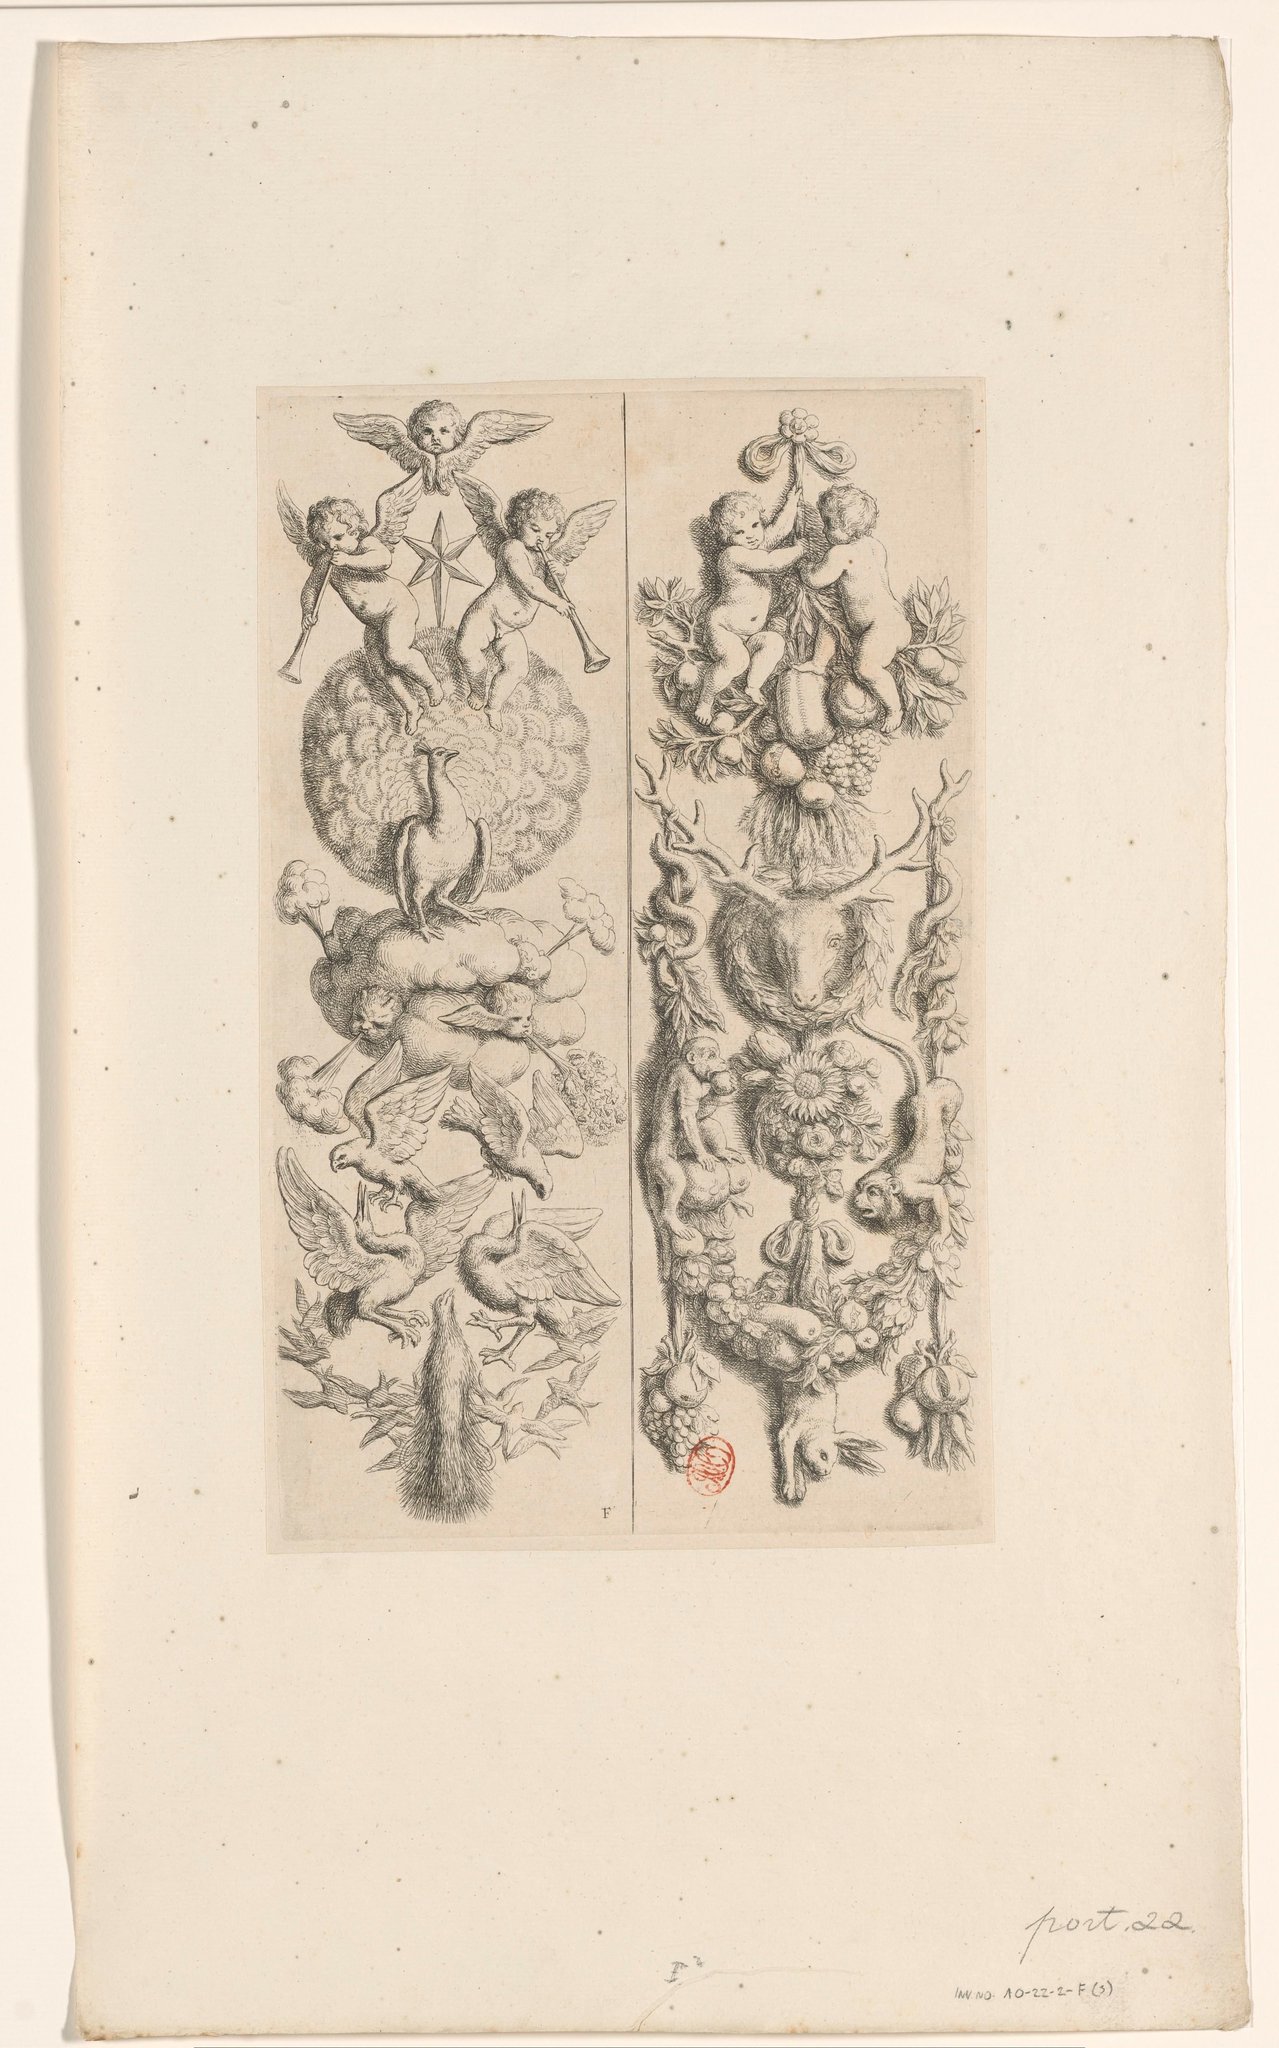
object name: book illustration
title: Festoenen met attributen van de personificaties van de elementen Lucht en Aarde aan oostzijde van de Burgerzaal in het Stadhuis op de Dam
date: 1663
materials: paper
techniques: engraving, etching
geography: amsterdam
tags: earth (one of the four elements), air (one of the four elements)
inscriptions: collector's mark: Lugt 195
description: Prent gebruikt in: Secunca pars Praecipuarum effigierum ac ornamentorum amplissime Curiae Amstelrodamensis maiori ex parte in cadido marmore effectorum per Artum Quellinium eiusdem Civitatis Statuarium / Het tweede deel Van de voornaemste Statuen ende Cieraten van 't konst-rijcke Stadt-huys van Amstelredam 'tmeeste in Marmer gemaeckt door Artus Quellinus Beelthouwer der voorseyde Stadt. Amsterdam: Artus Quellinus (I), 1663.* Zie RP-P-AO-22-2-1 voor bijhorende titelpagina. Zie RP-P-AO-22-2-2 voor bijhorend register.* Zie RP-P-AO-22-2A, RP-P-AO-22-2B, RP-P-AO-22-2C-1, RP-P-AO-22-2C-2, RP-P-AO-22-2C-3, RP-P-AO-22-2C-4, RP-P-AO-22-2D-1, RP-P-AO-22-2D-2, RP-P-AO-22-2D-3, RP-P-AO-22-2E-1, RP-P-AO-22-2E-2, RP-P-AO-22-2E-3, RP-P-AO-22-2E-4, RP-P-AO-22-2F-1, RP-P-AO-22-2F-2, RP-P-AO-22-2G, RP-P-AO-22-2H, RP-P-AO-22-2I, RP-P-AO-22-2K, RP-P-AO-22-2L, RP-P-AO-22-2M, RP-P-AO-22-2N, RP-P-AO-22-2O-1, RP-P-AO-22-2O-2, RP-P-AO-22-2O-3, RP-P-AO-22-2O-4, RP-P-AO-22-2O-5, RP-P-AO-22-2O-6, RP-P-AO-22-2O-7, RP-P-AO-22-2P-1, RP-P-AO-22-2P-2, RP-P-AO-22-2Q-1, RP-P-AO-22-2Q-2, RP-P-AO-22-2Q-3, RP-P-AO-22-2R-1, RP-P-AO-22-2R-2, RP-P-AO-22-2R-3, RP-P-AO-22-2S, RP-P-AO-22-2T-1, RP-P-AO-22-2T-2, RP-P-AO-22-2T-3, RP-P-AO-22-2T-4, RP-P-AO-22-2V-1, RP-P-AO-22-2V-2, RP-P-AO-22-2W-1, RP-P-AO-22-2W-2, RP-P-AO-22-2X-1, RP-P-AO-22-2X-2 en RP-P-AO-22-2X-3 voor andere prenten uit deze publicatie. Zelfde staat van prent ook gebruikt in: Secunca pars Praecipuarum effigierum ac ornamentorum amplissime Curiae Amstelrodamensis maiori ex parte in cadido marmore effectorum per Artum Quellinium eiusdem Civitatis Statuarium / Het tweede deel Van de voornaemste Statuen ende Cieraten van 't konst-rijcke Stadt-huys van Amstelredam 'tmeeste in Marmer gemaeckt door Artus Quellinus Beelthouwer der voorseyde Stadt. Amsterdam: Frederik de Wit, 1668. Latere staat van prent ook gebruikt in: Architecture peinture et sculpture de la Maison de Ville d'Amsterdam, representee en CIX. figures en taille-douce (…). Amsterdam: David Mortier, 1719. En in: Architecture peinture et sculpture de la Maison de Ville d'Amsterdam, representee en CIX. figures en taille-douce (…). Amsterdam: Gerard Valck, 1719. En in: Bouw schilder en beeldhouwkonst, van het Stadhuis te Amsteldam, vertoont in CIX figuuren (…). Amsterdam: Covens & Mortier & Covens Jr., s.a. (1774-1783). * Volgens het register in deze publicatie zouden deze festoenen zich boven de reliëfs met de personificaties van de elementen Lucht en Aarde aan de westzijde van de Burgerzaal (RP-P-AO-22-2E-4 en RP-P-AO-22-2E-1) moeten zitten. Ze zijn echter boven de andere reliëfs van deze elementen, aan de oostzijde van de Burgerzaal (RP-P-AO-22-2C-2 en RP-P-AO-22-2C-4) geplaatst.